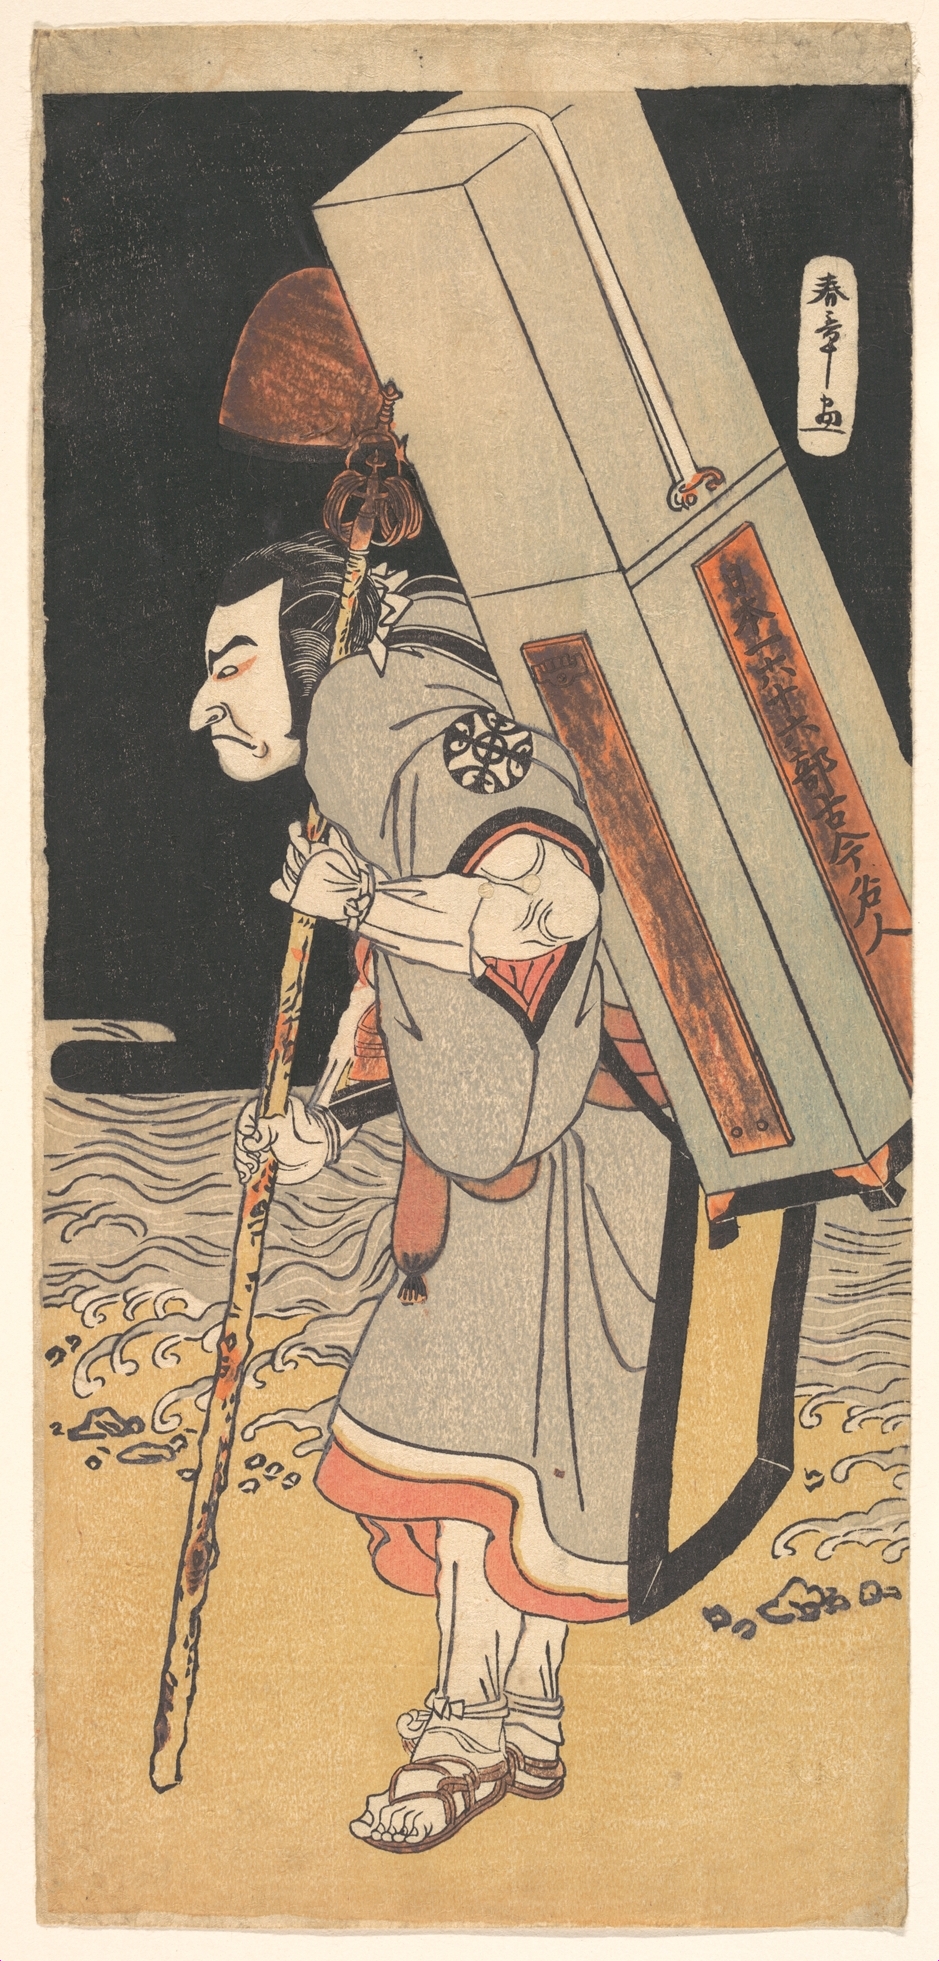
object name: woodblock print nishiki e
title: The actor Nakamura Nakazo as a rokuju-rokubu (pilgrim to Buddhist temple)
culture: japanese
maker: katsukawa shunshō 勝川春章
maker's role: artist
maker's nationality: japanese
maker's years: 1726-1792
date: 1780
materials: ink, paper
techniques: nishiki e, woodblock print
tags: men,actors